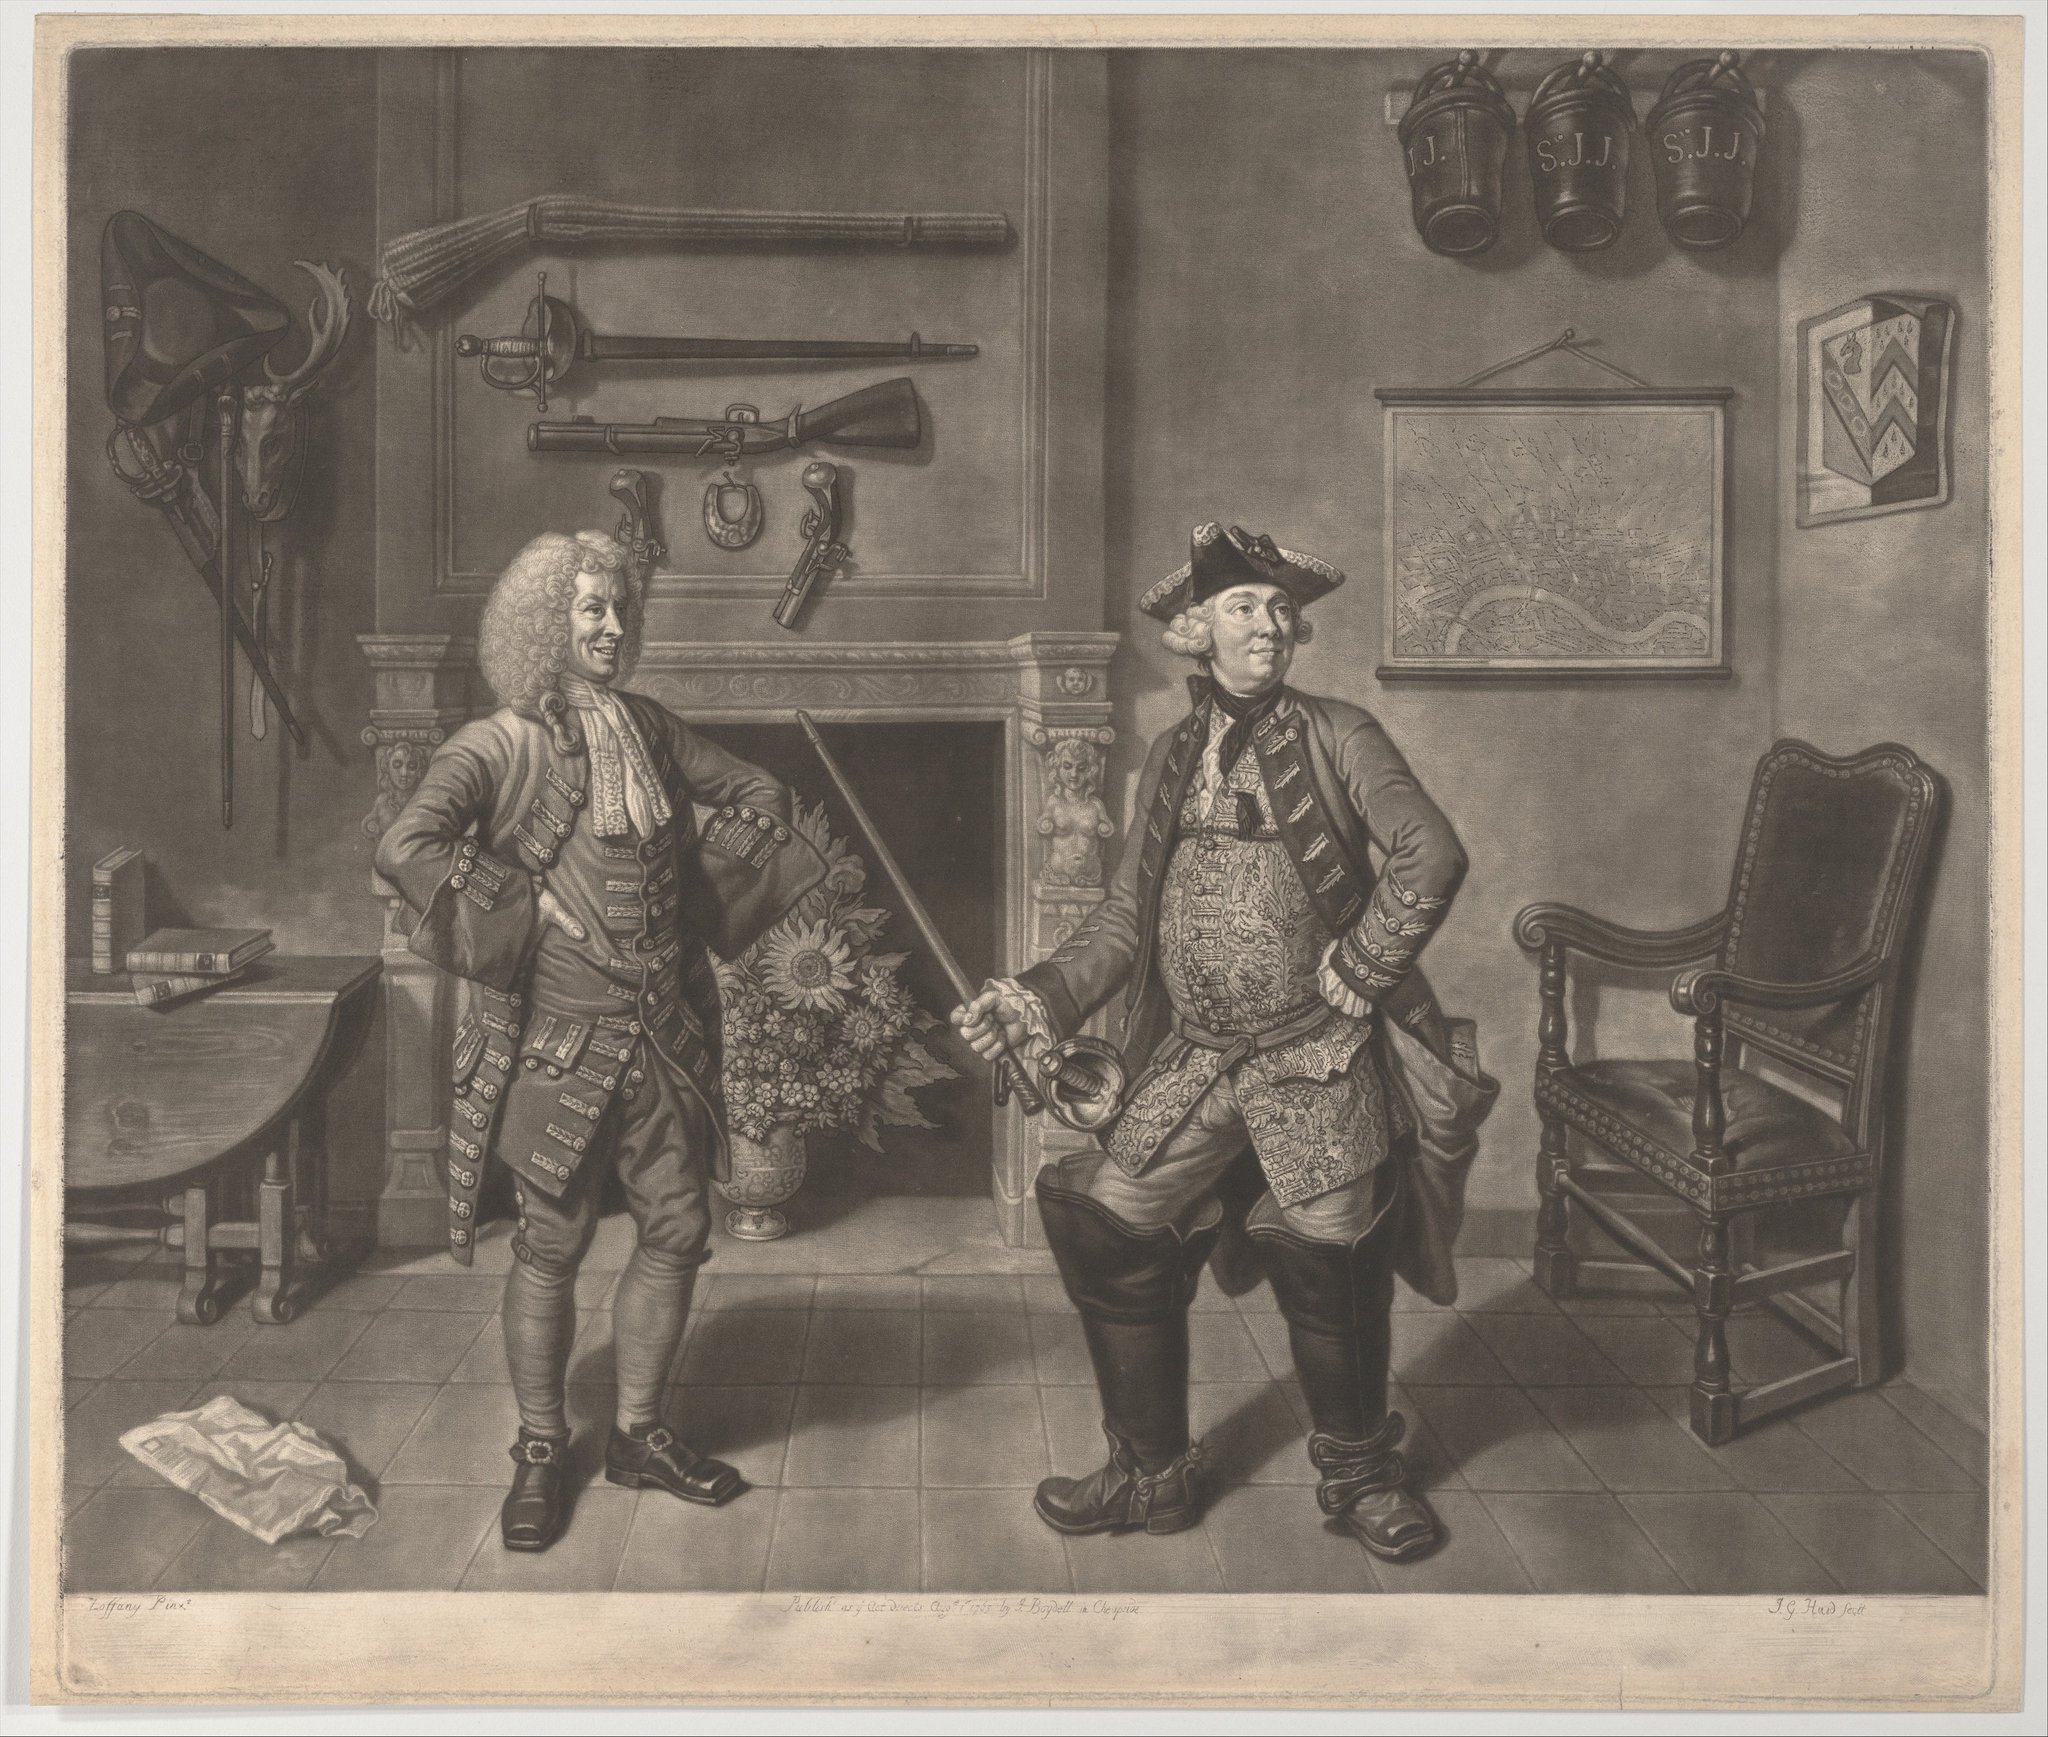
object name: print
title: Mr. Foote in the Character of Major Sturgeon, in the Mayor of Garratt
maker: johann gottfried haid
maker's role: artist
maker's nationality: german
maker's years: 1714-1776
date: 1765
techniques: mezzotint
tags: firearms,men